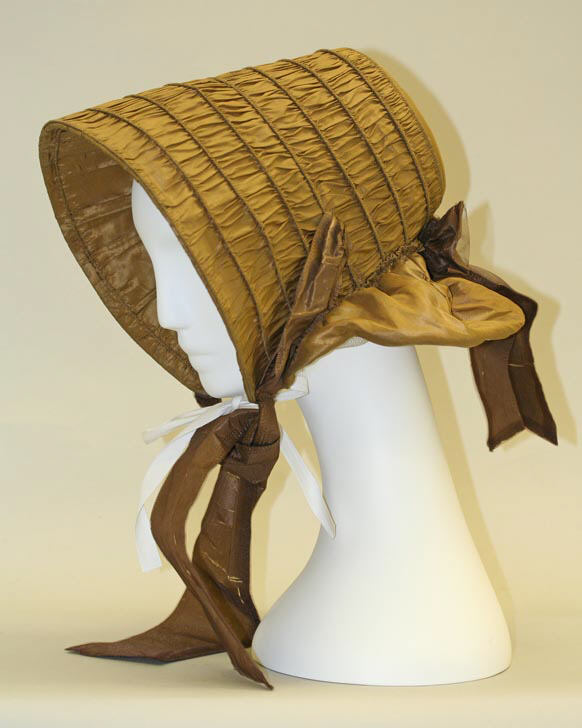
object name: capote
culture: american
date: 1840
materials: silk, metal